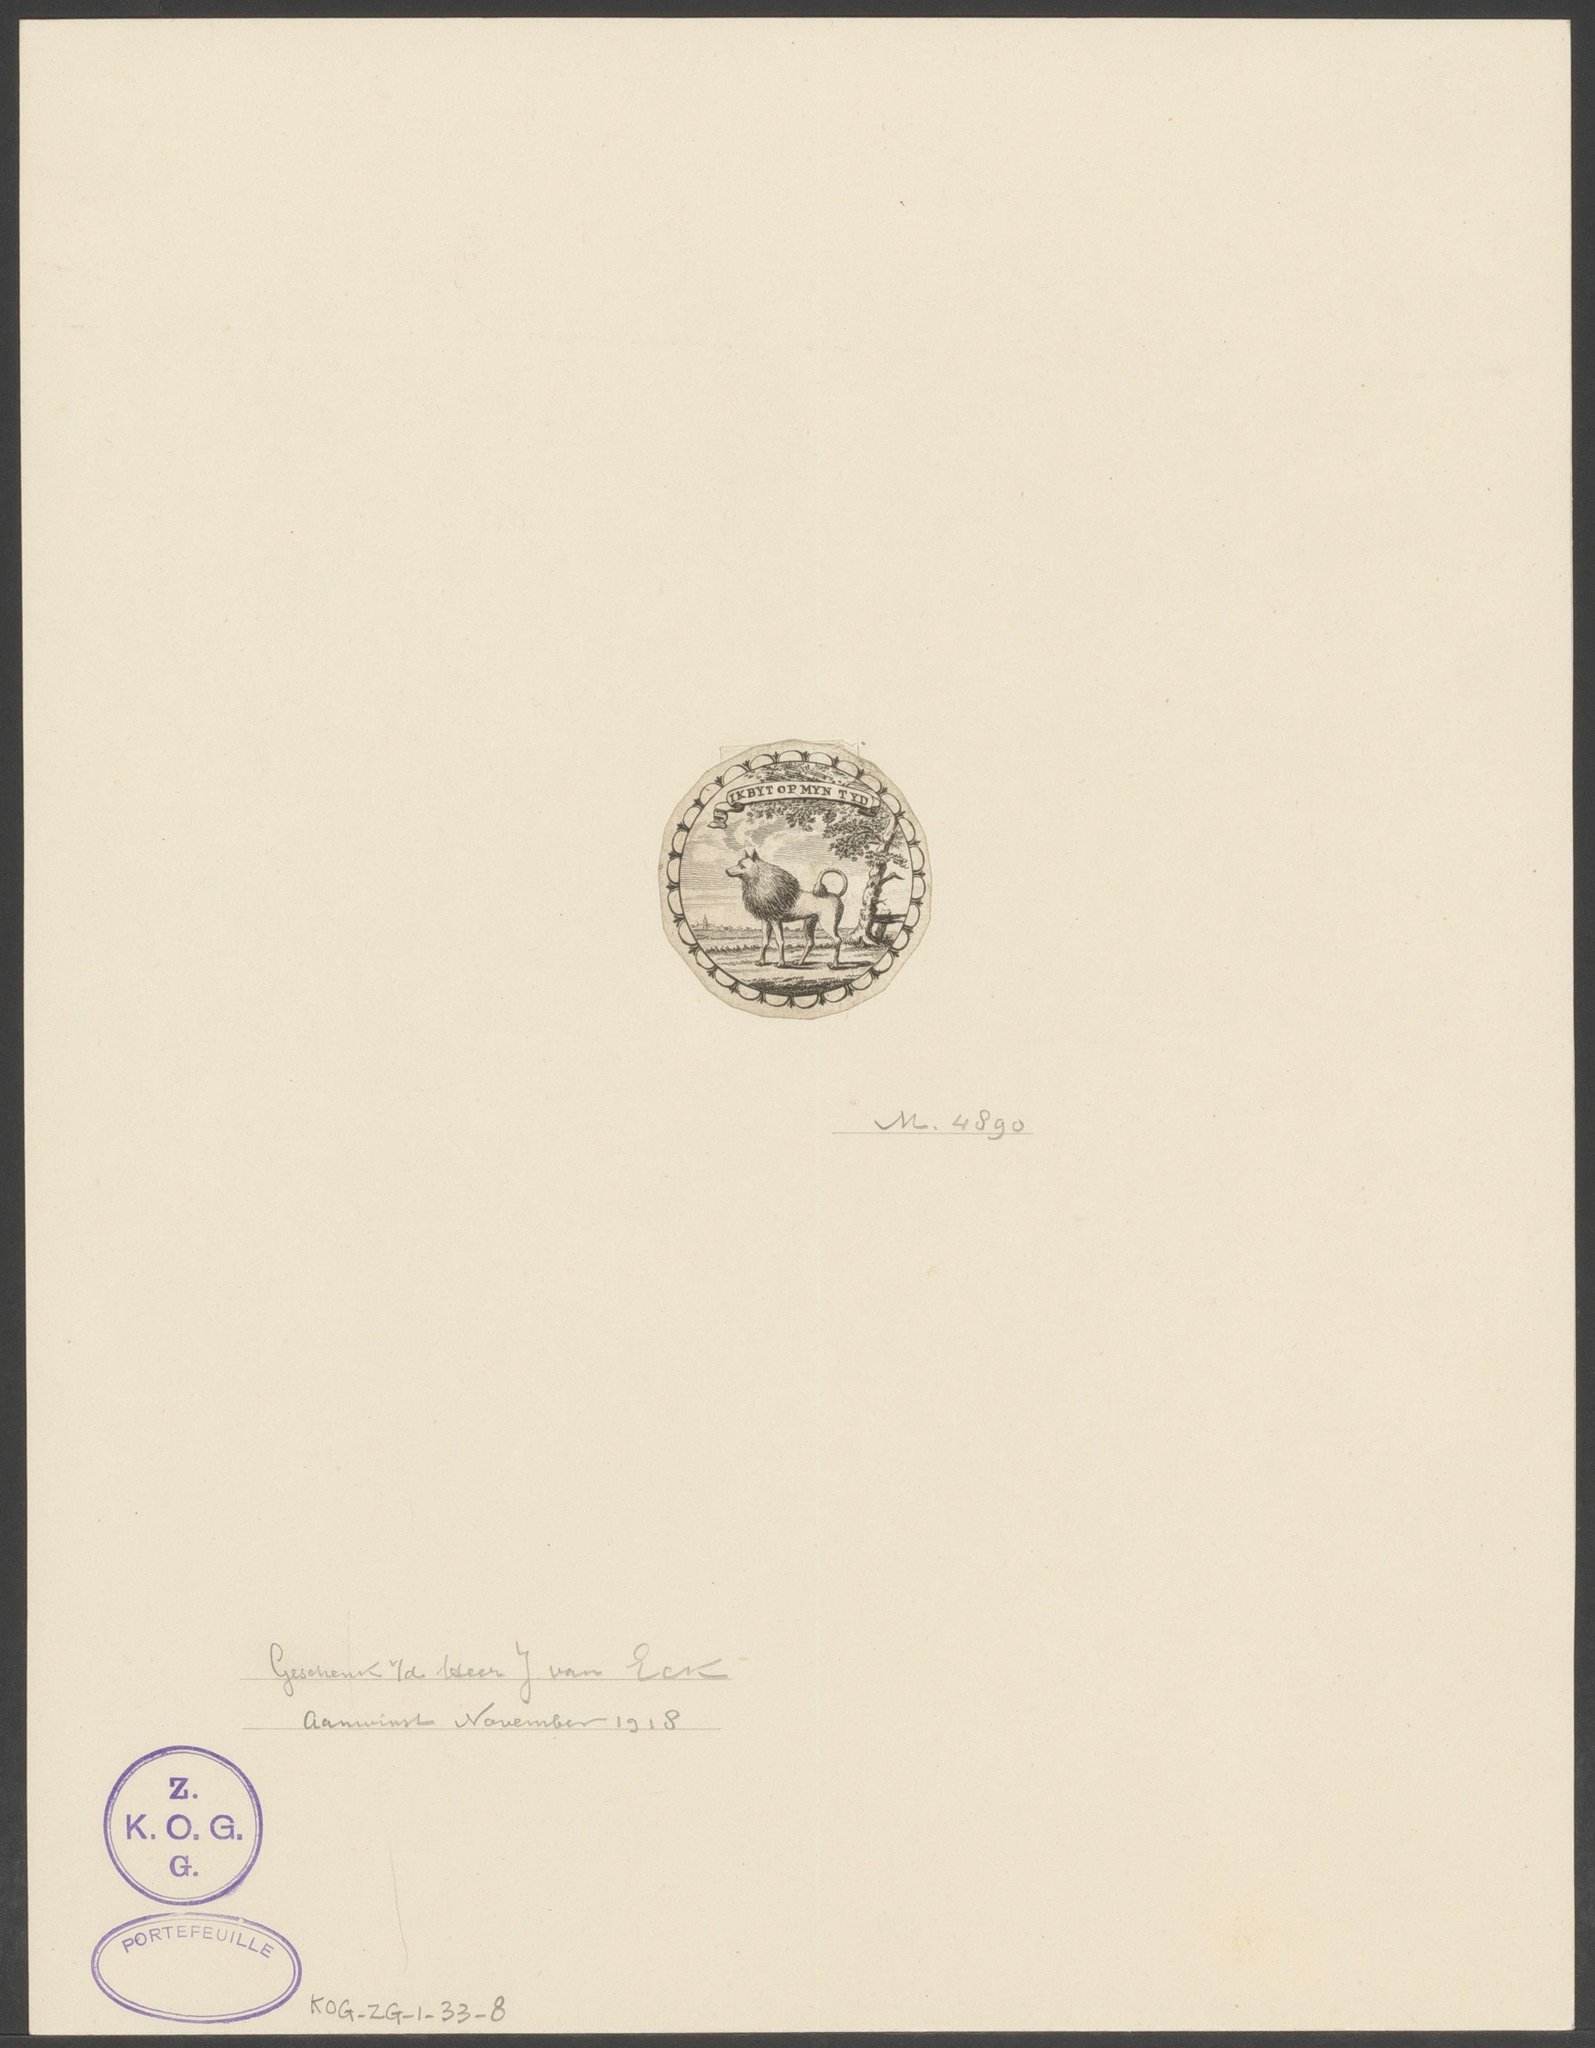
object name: print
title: Embleem met keeshond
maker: Anonymous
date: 1787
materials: paper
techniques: etching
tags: dog, patriots (1780-1795)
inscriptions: collector's mark: Lugt 1641, stamp